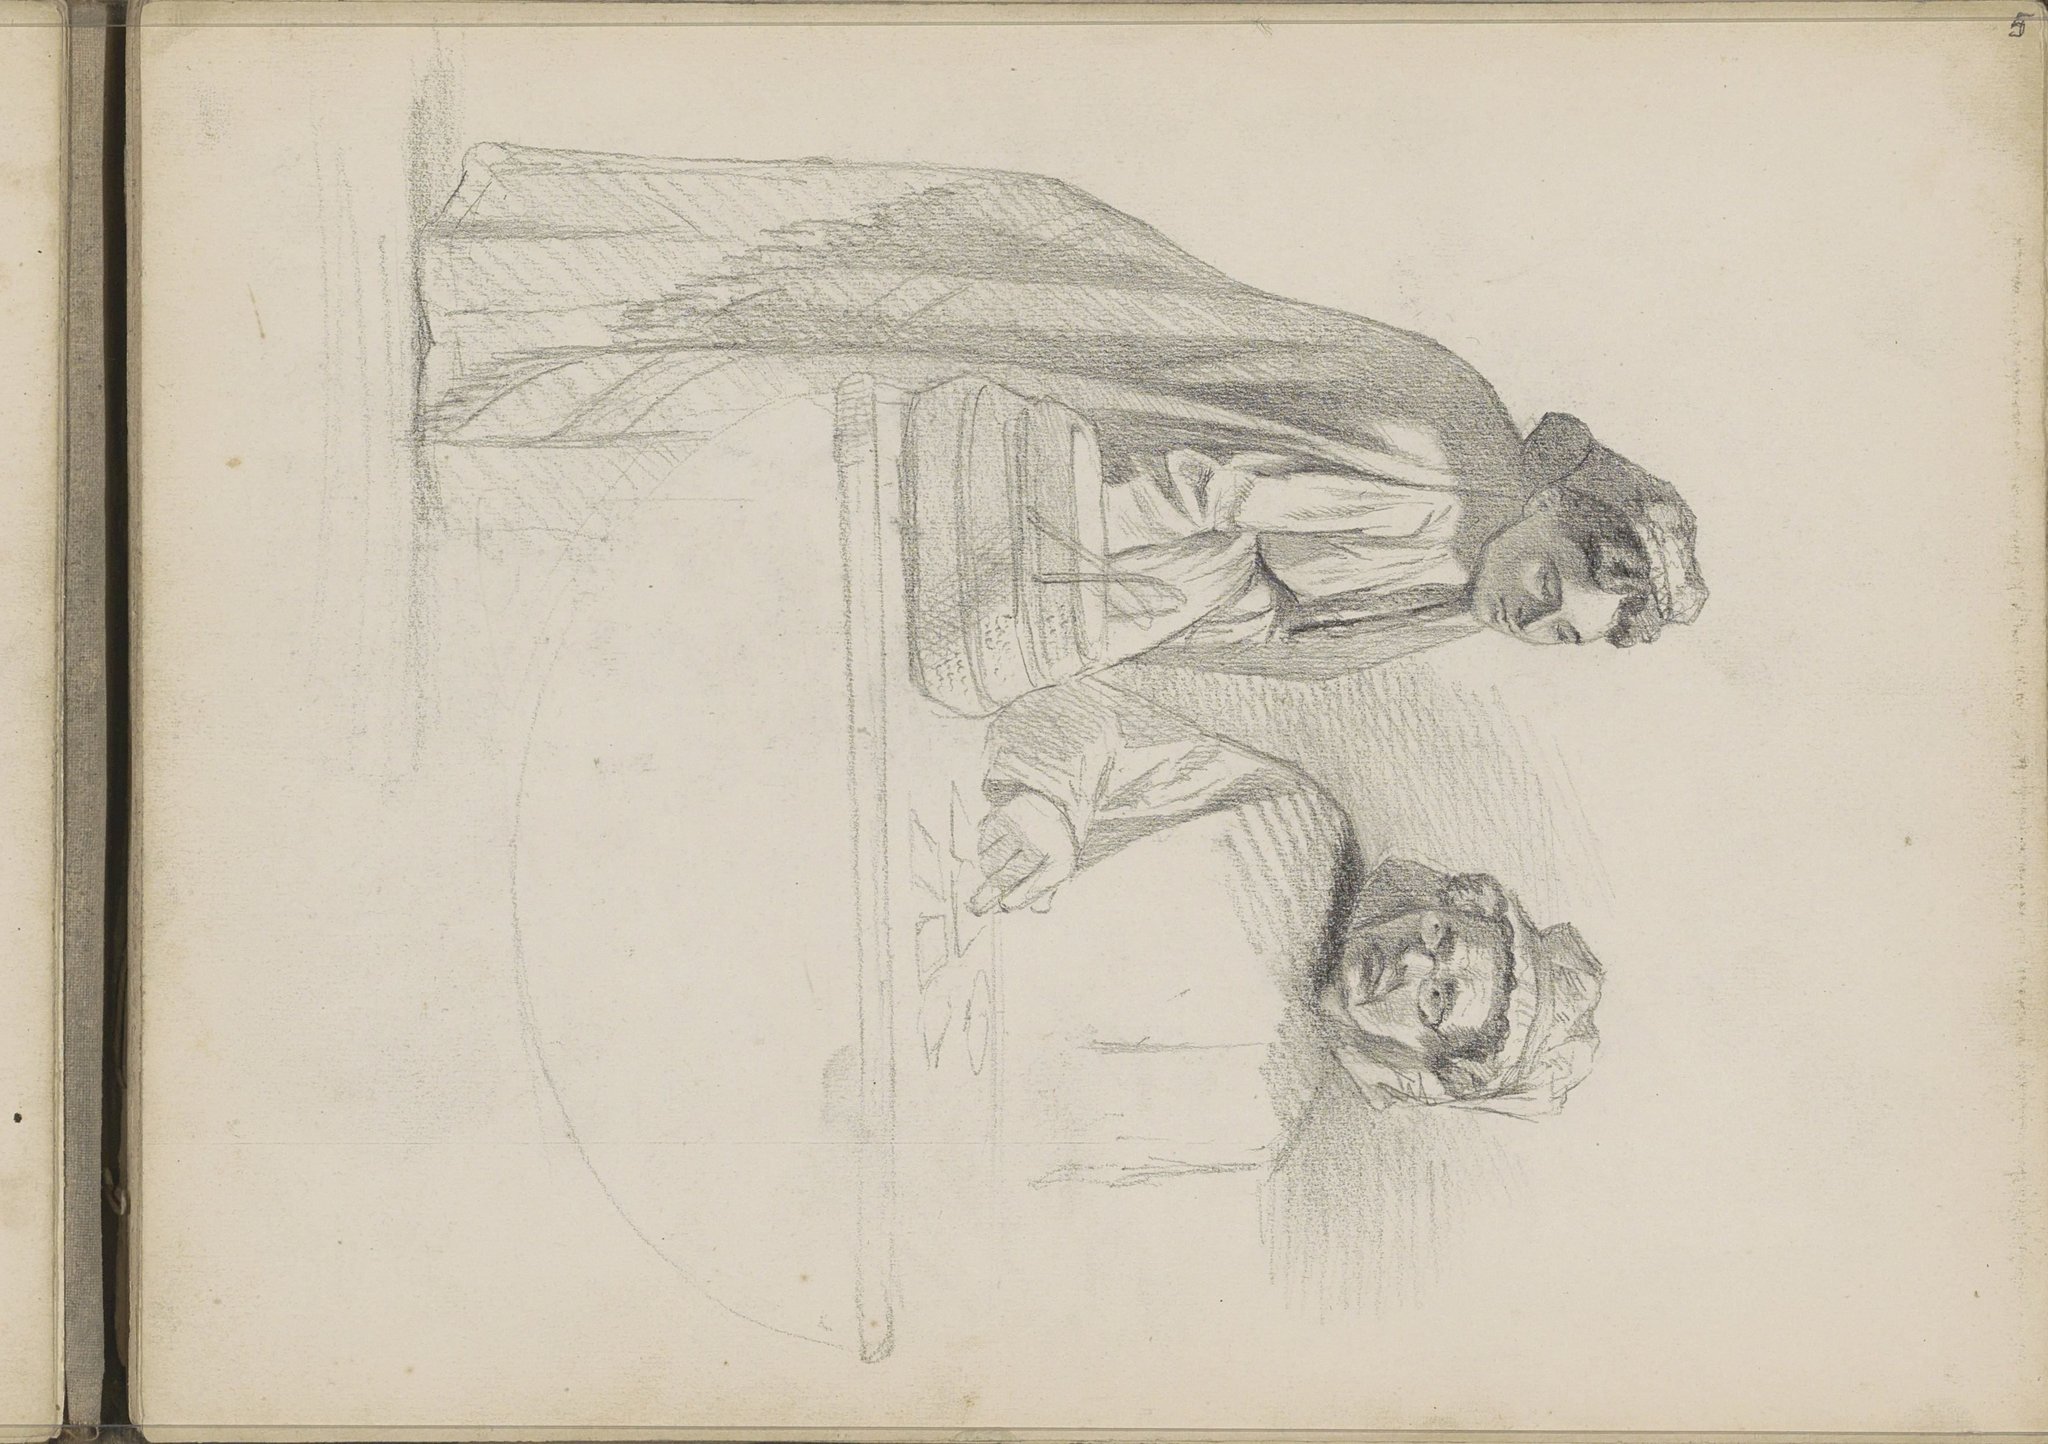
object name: sketchbook leaf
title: Twee kaartspeelsters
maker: willem cornelis rip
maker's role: draughtsman, painter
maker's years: 1856-1922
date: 1874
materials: paper, pencil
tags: sitting figure - aa - female human figure, playing-cards (+ sportsman, player, etc.)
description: Eén vrouw spreidt de kaarten uit op een tafel terwijl de andere vrouw toekijkt. Blad 5 recto uit een schetsboek met 27 losse bladen.